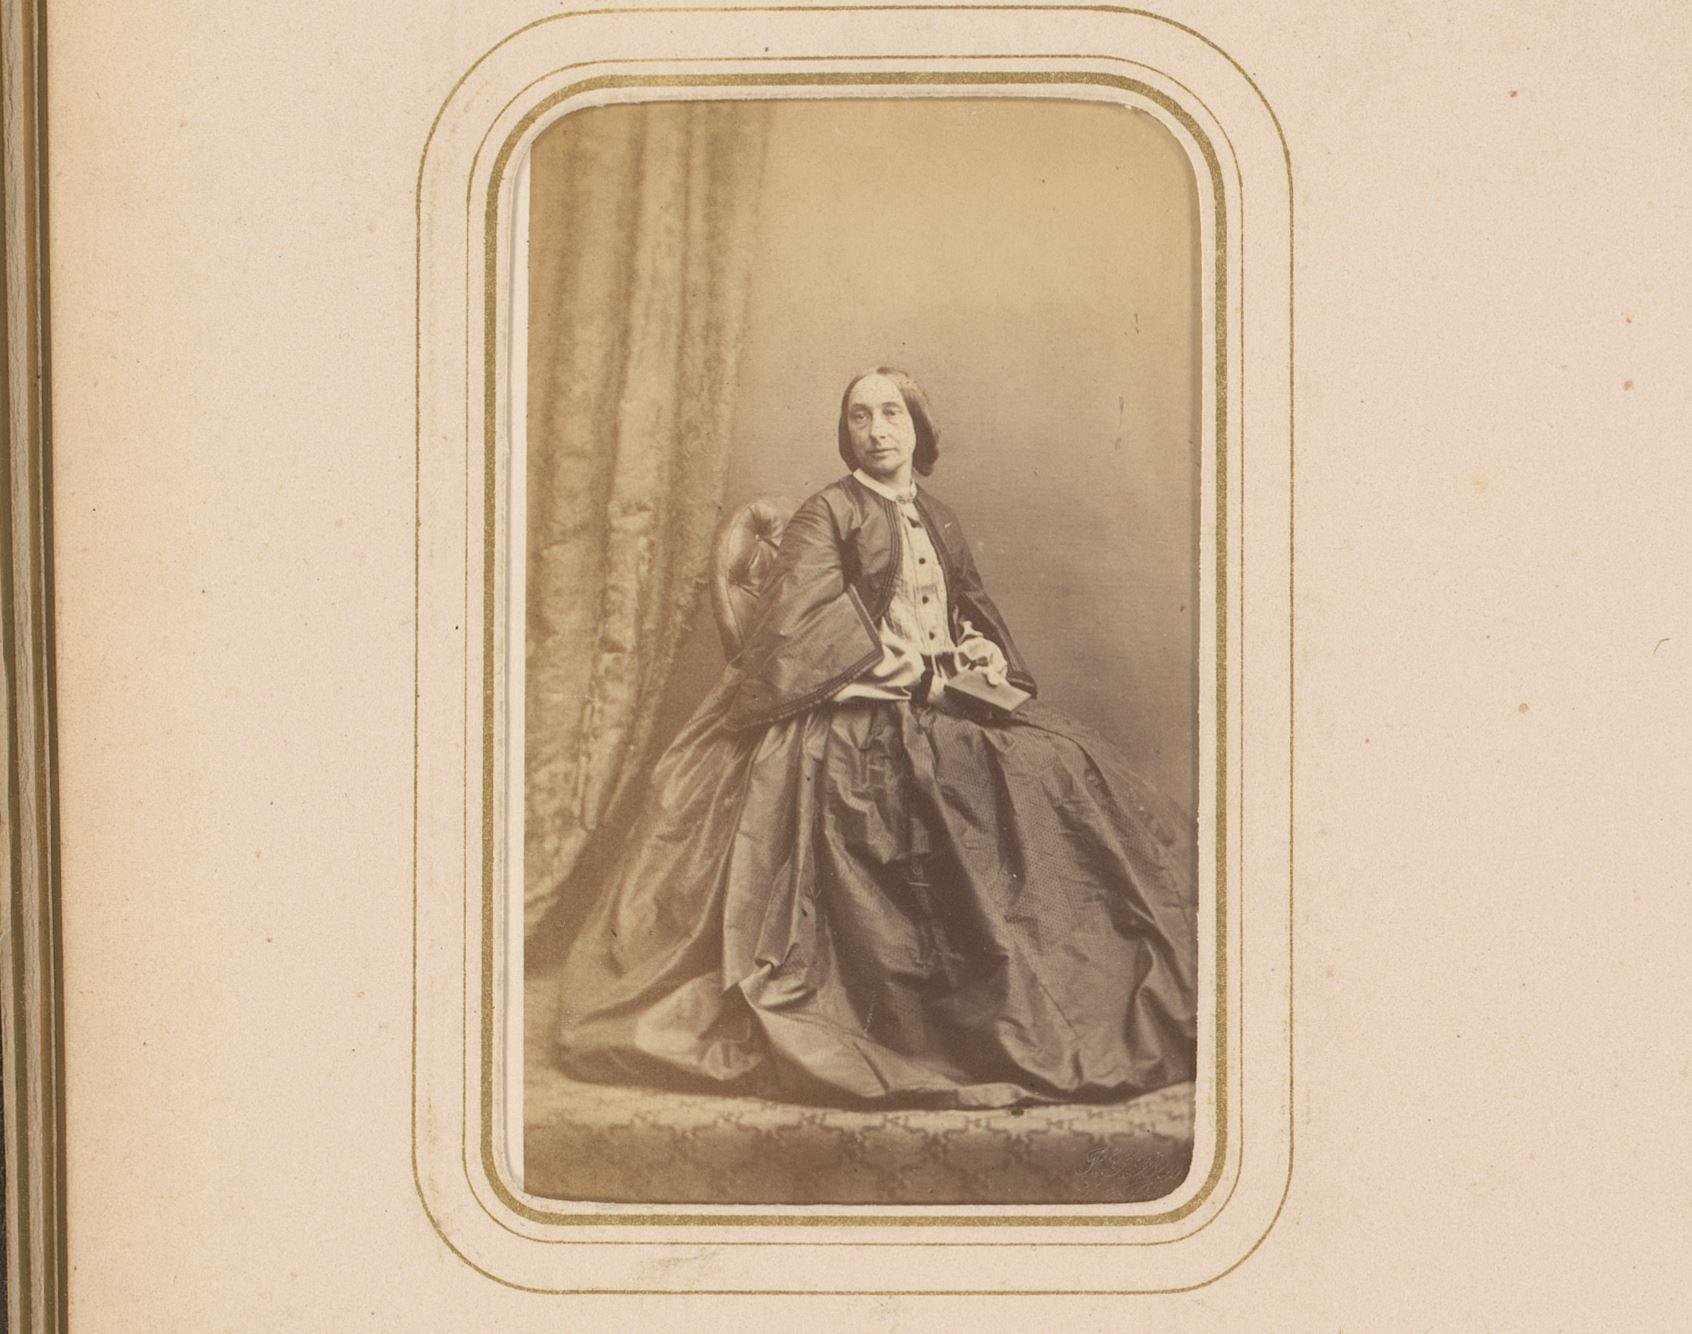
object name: photograph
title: Portret van een zittende vrouw met boek in de hand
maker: Anonymous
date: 1860-1890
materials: cardboard, photographic support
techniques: albumen print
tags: sitting figure - aa - female human figure, historical persons - bb - woman, book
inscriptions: number: ‘13533’